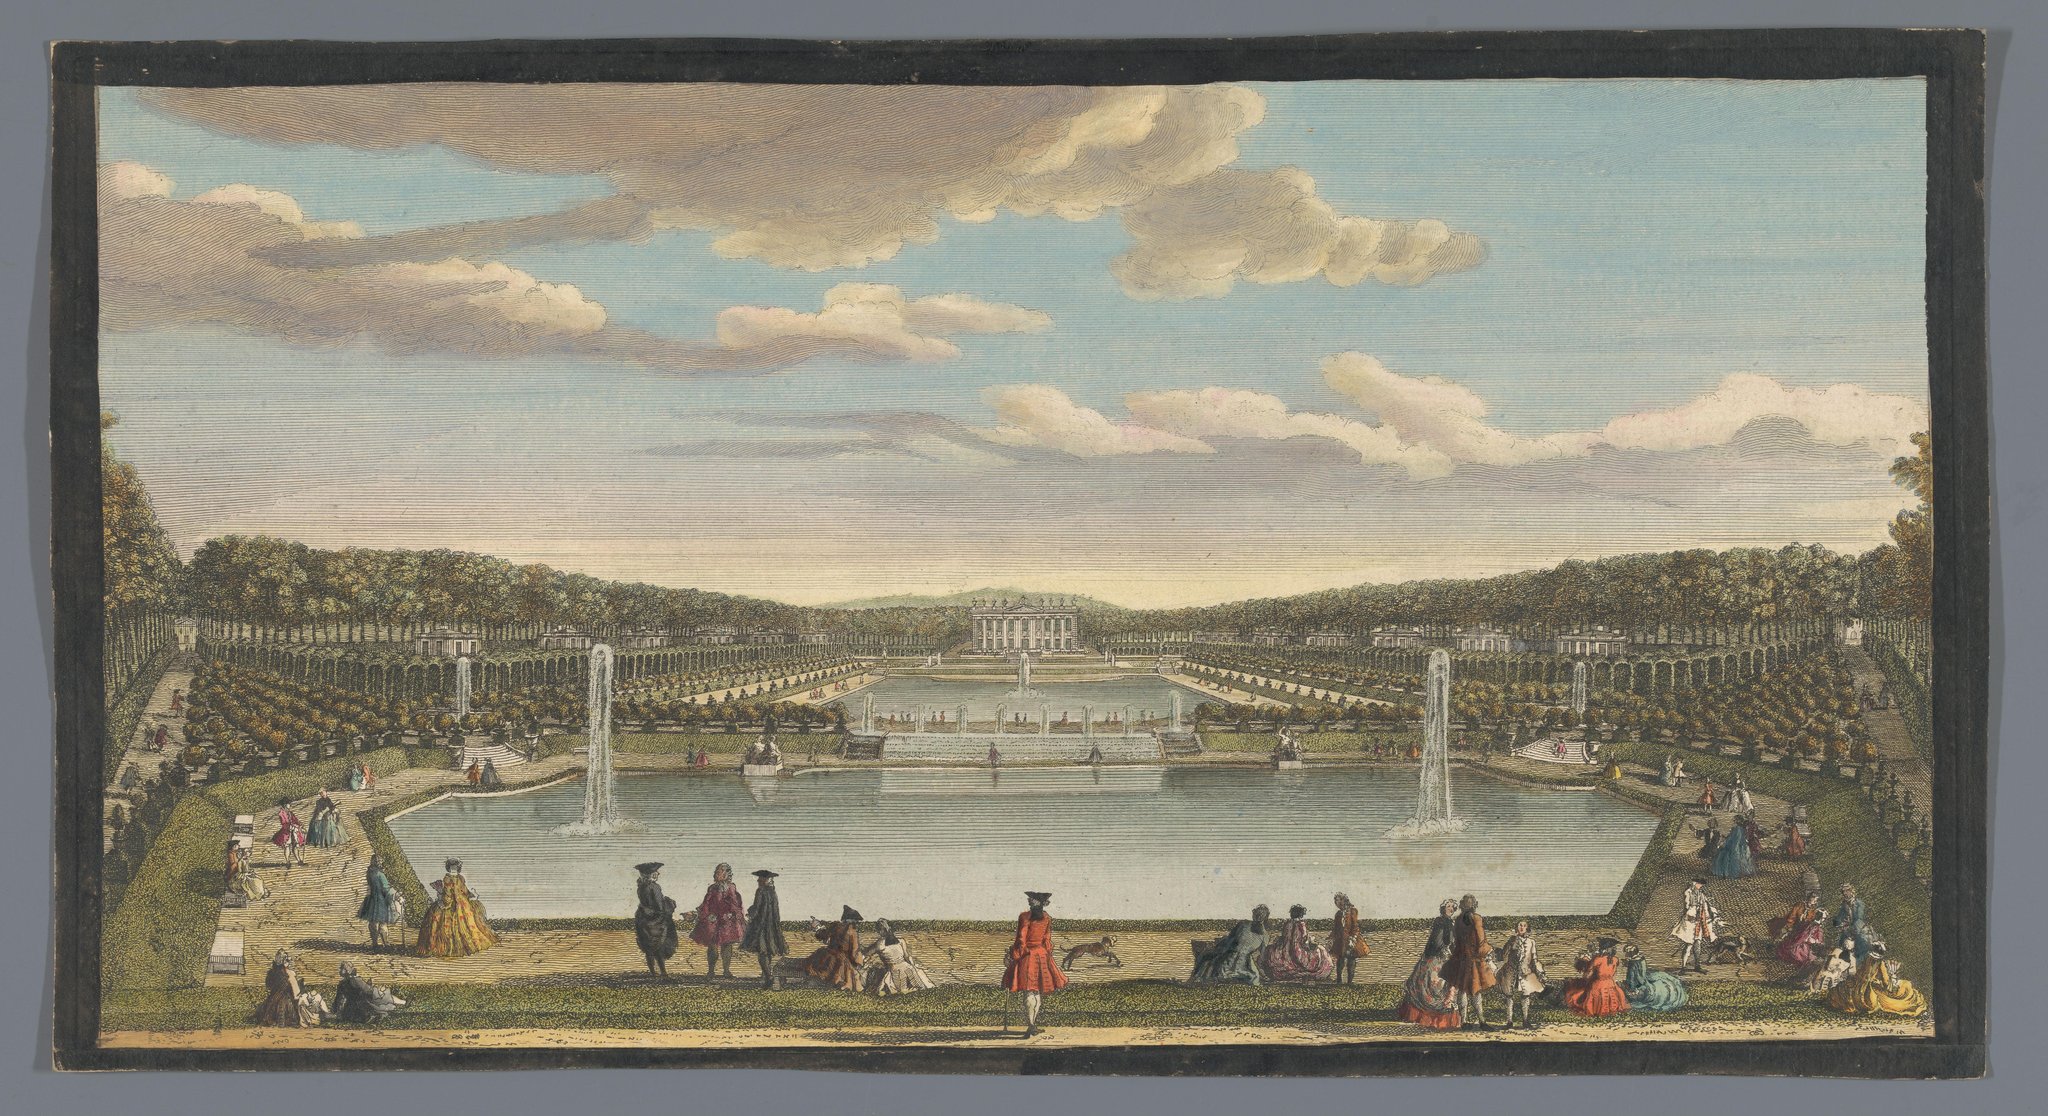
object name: opticaprent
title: A view of ye. Palace of Marli from ye. bottom of ye. great parterre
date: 1700-1761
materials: cardboard, paper, watercolor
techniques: brush, etching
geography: london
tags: civic architecture; edifices; dwellings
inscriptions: inscription: ‘Fo 21 B4’